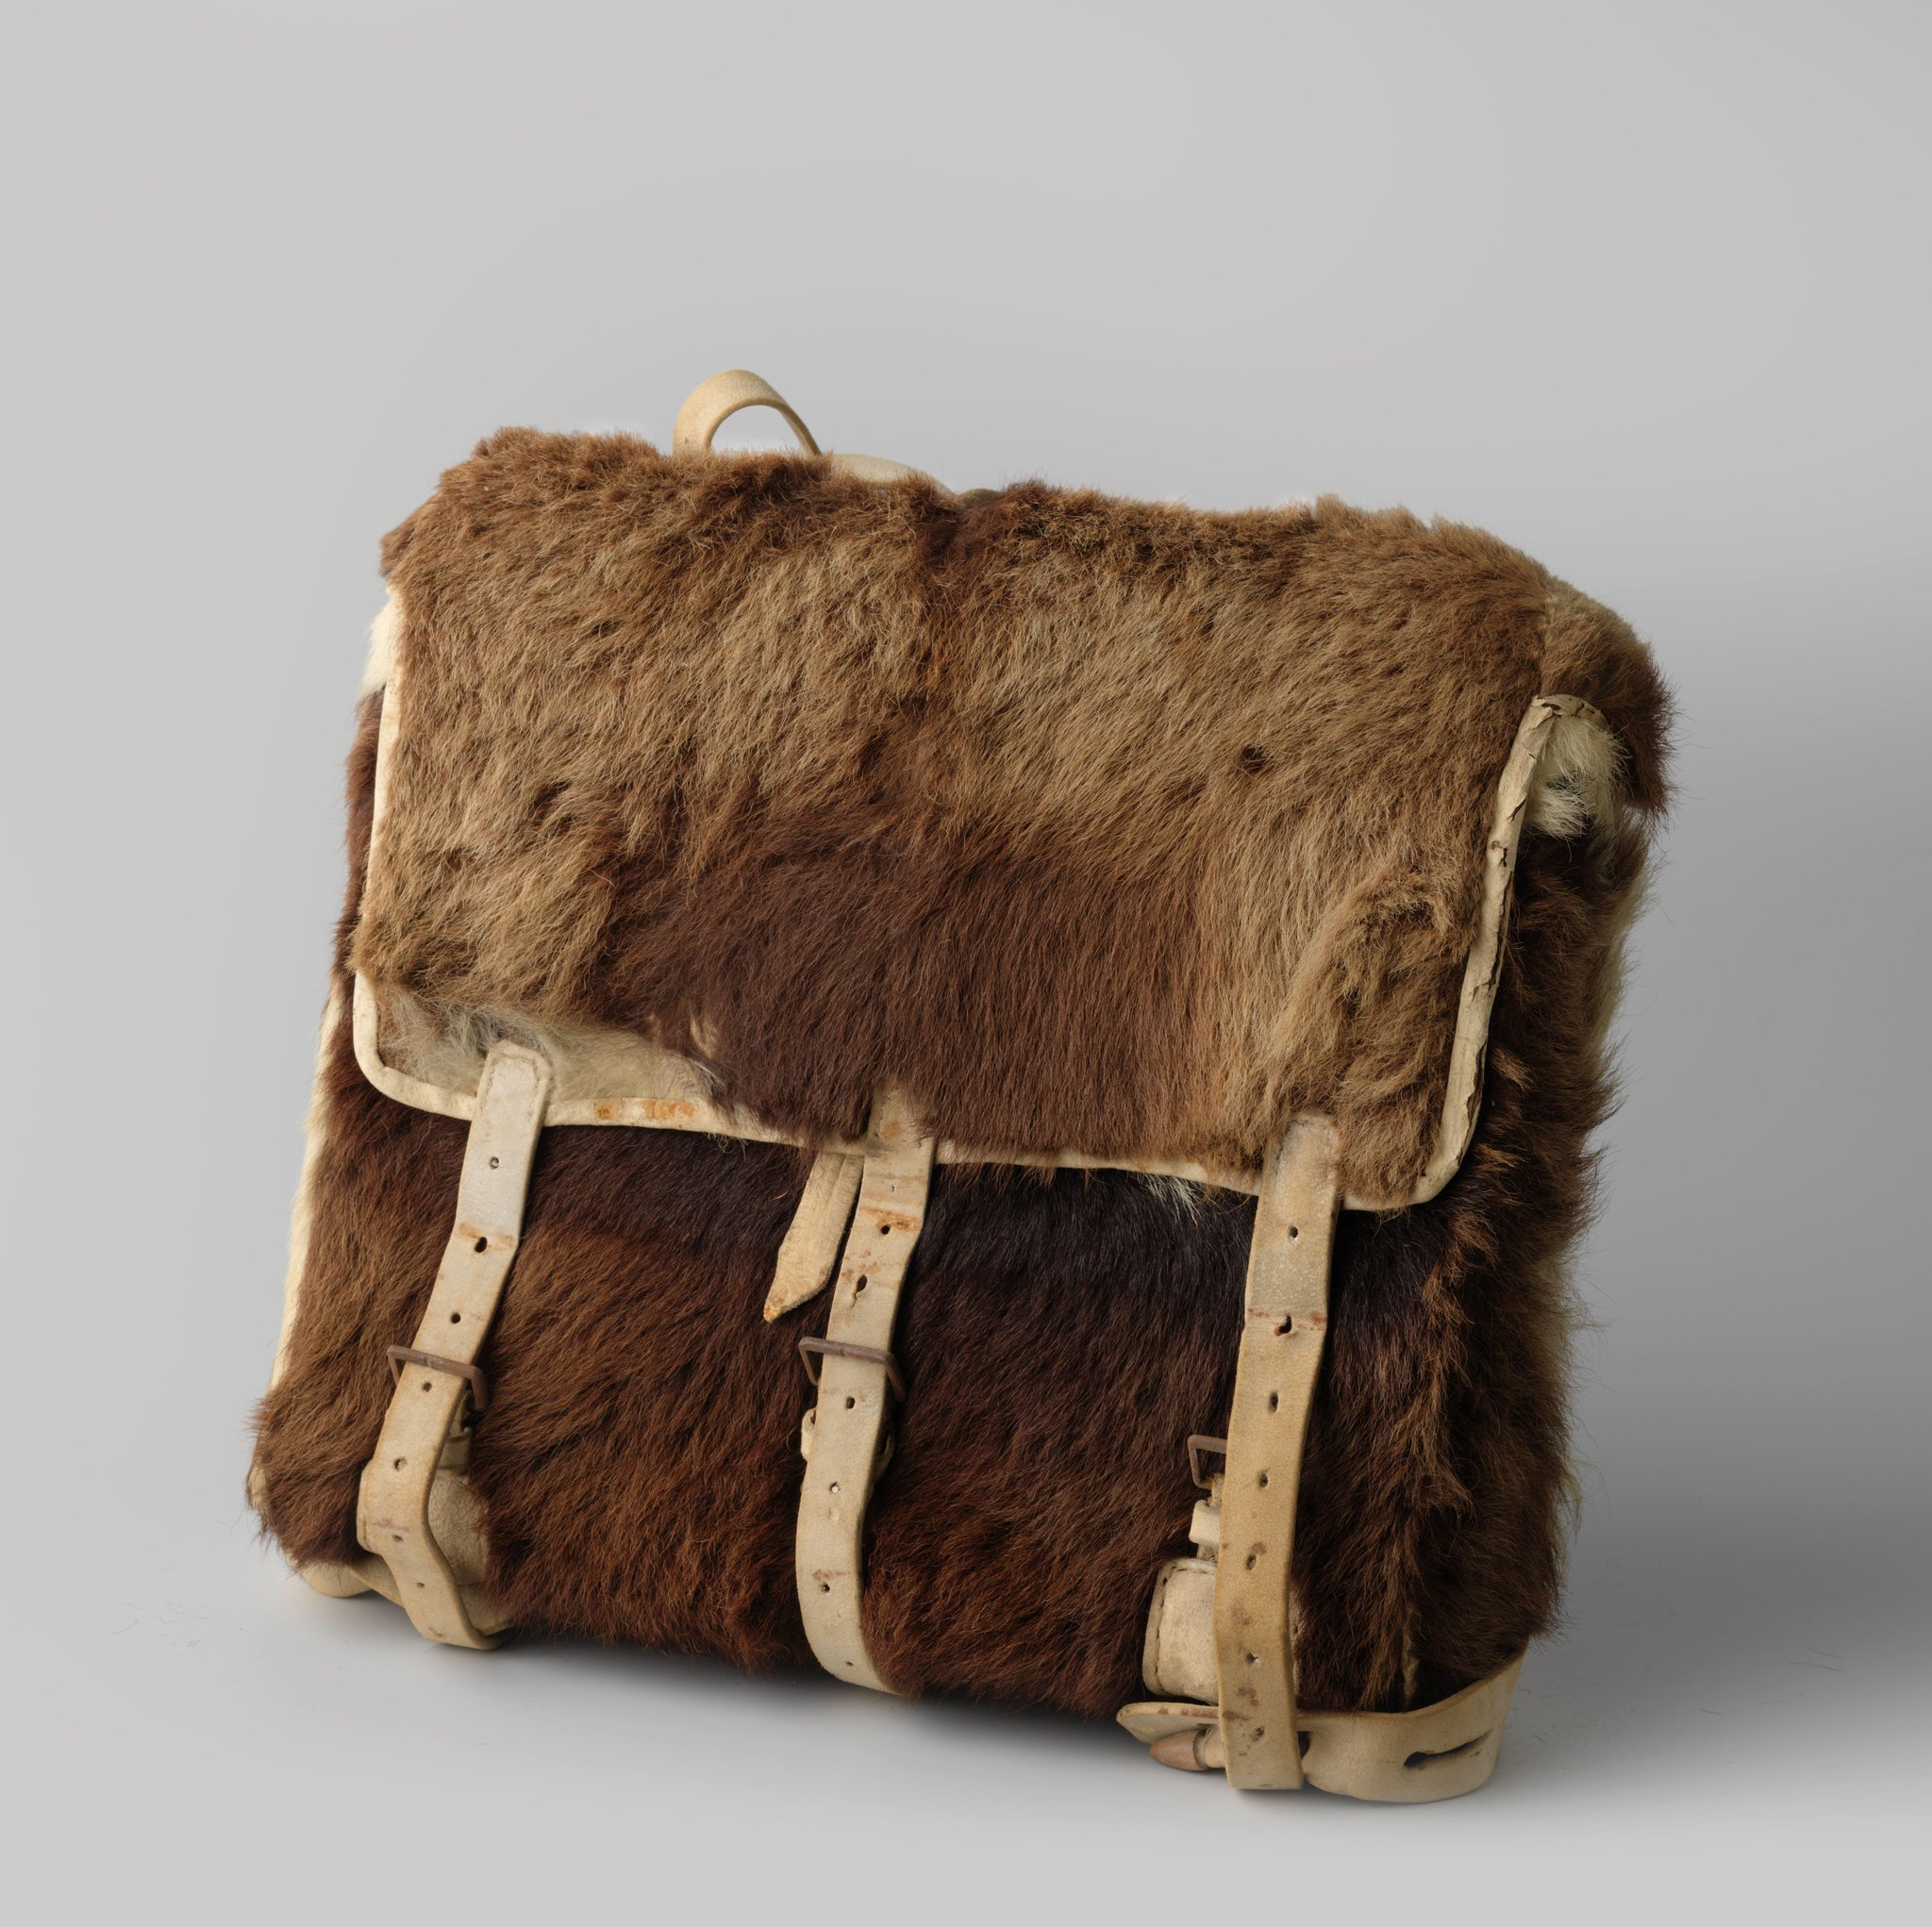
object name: combat rucksack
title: Een ransel met draagriemen gedragen door J. Boelen Jkzn., in 1830/32 Vrijwillige Flankeur, later korporaal Holl. Schutterij, 1e Afd. 1e Bat.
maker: Anonymous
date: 1800-1830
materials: fur, iron, leather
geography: netherlands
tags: j. boelen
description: Een geweer met bajonet, een ransel, een veldketeltje, een wapenrok met wingsen, een halsdas, een sabelkwast, twee zakpistolen - J. Boelen J. Kz. in 1830.32 Vrijw. Flankeur, later Korporaal N.H.Schutterij 1e Afd. 1e Bat.